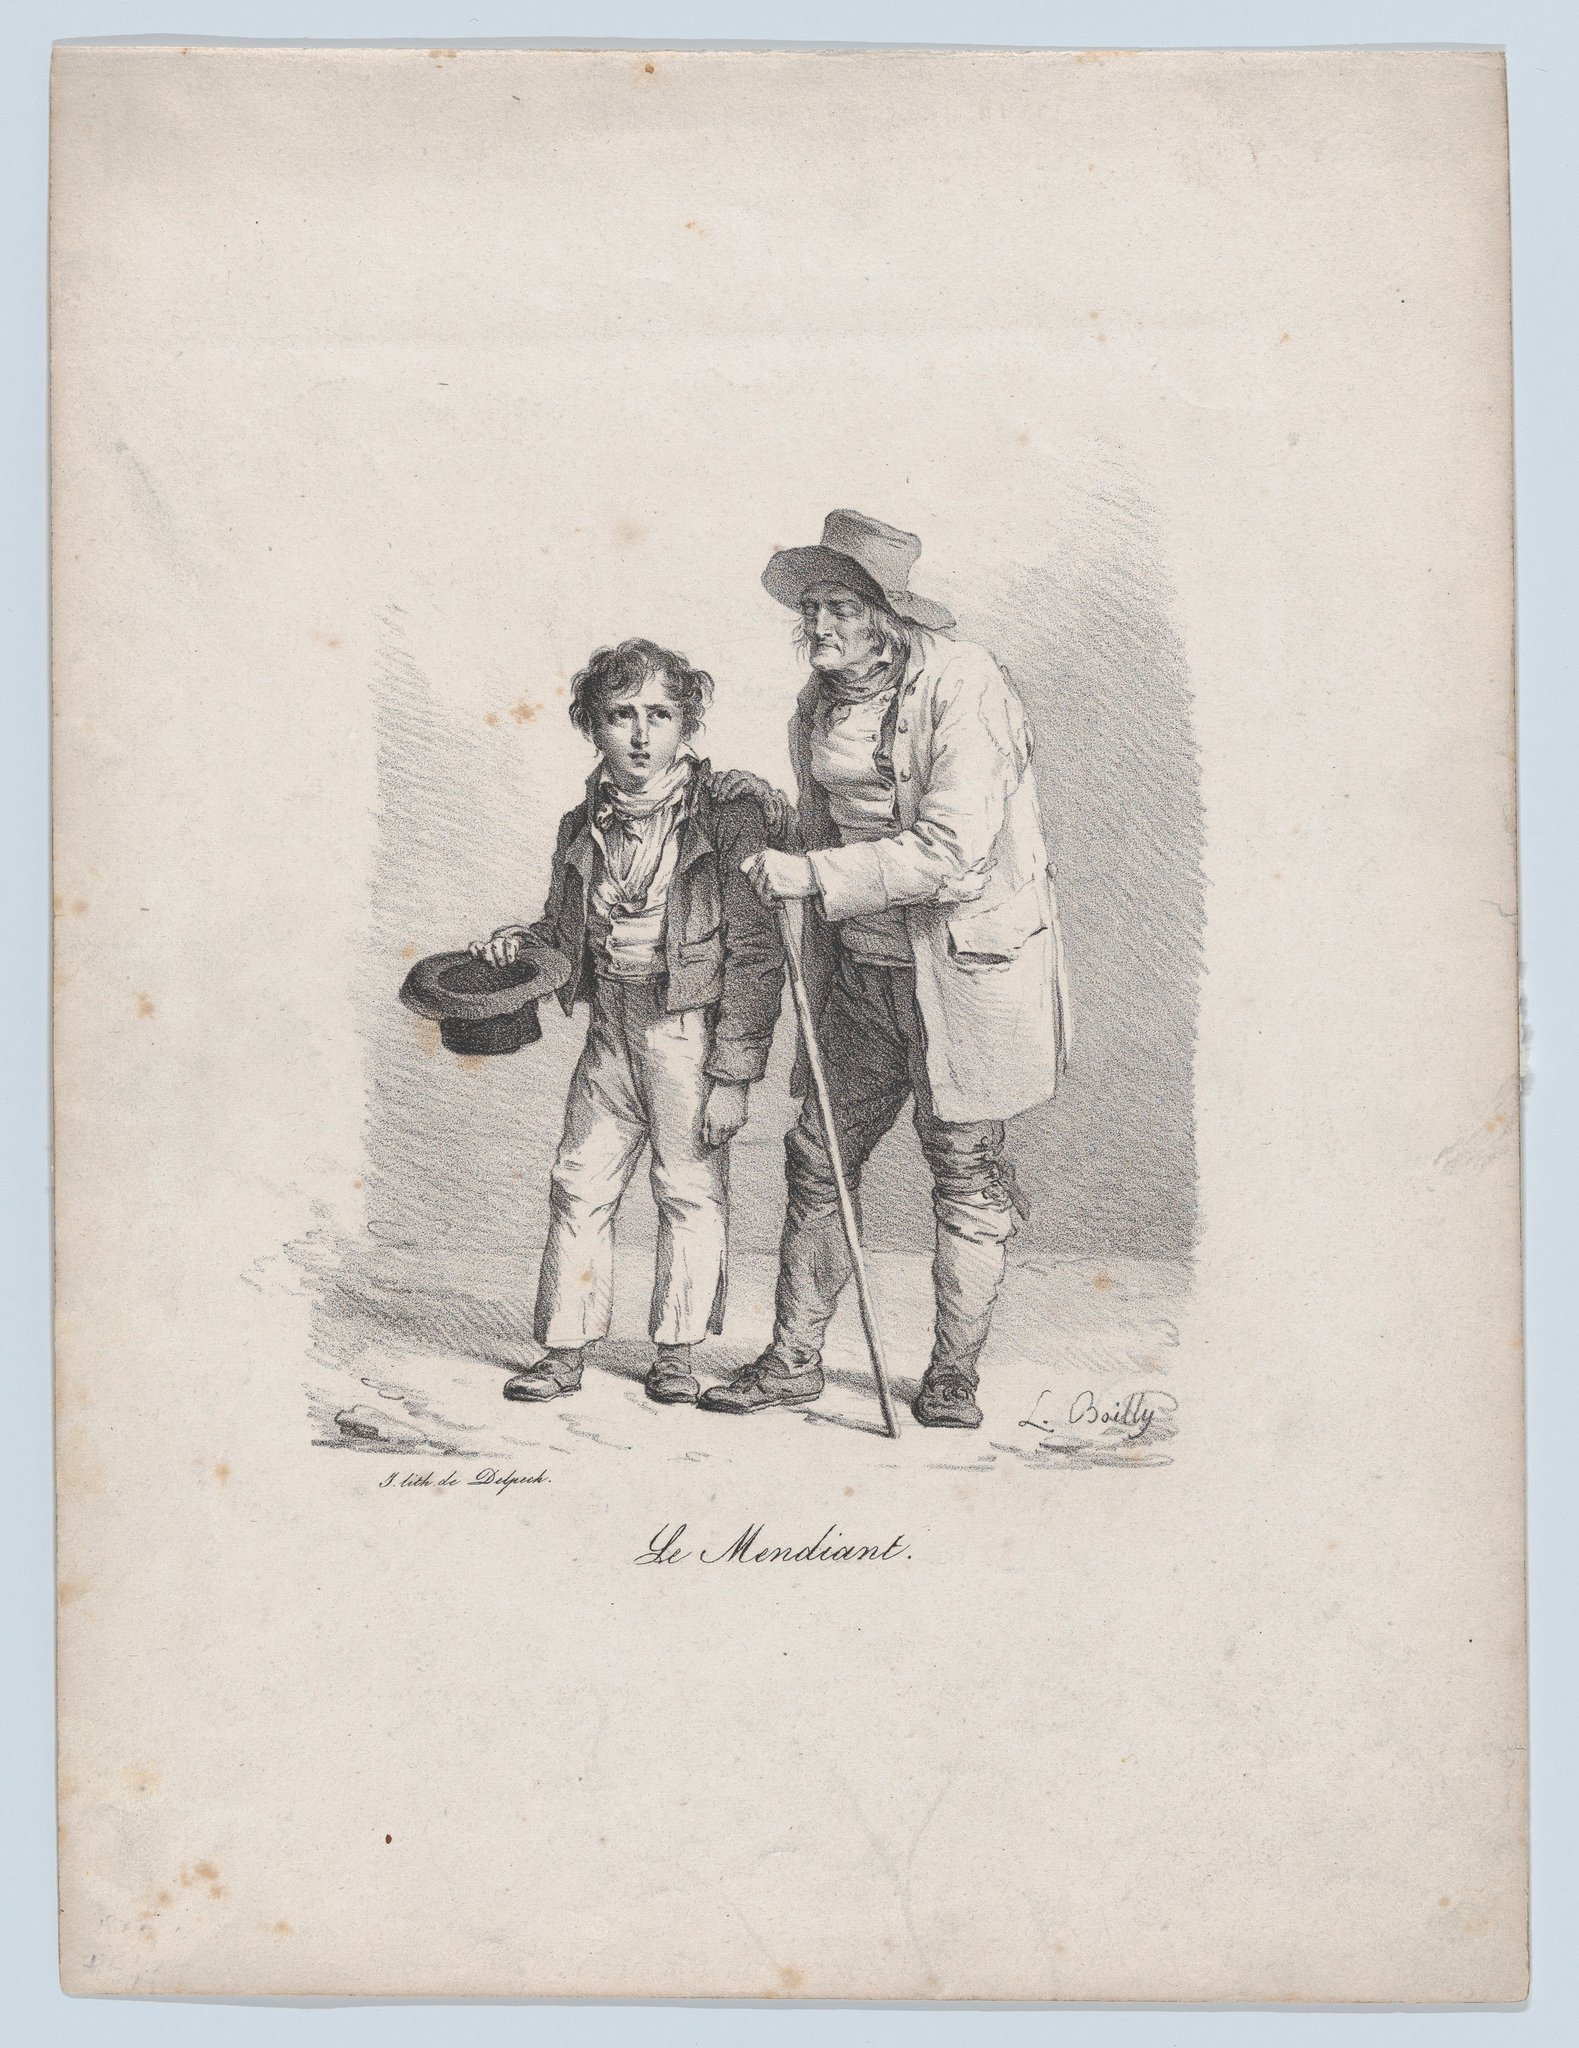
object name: print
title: The Beggar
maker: louis léopold boilly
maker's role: artist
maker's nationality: french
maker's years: 1761-1845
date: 1822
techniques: lithograph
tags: boys,men